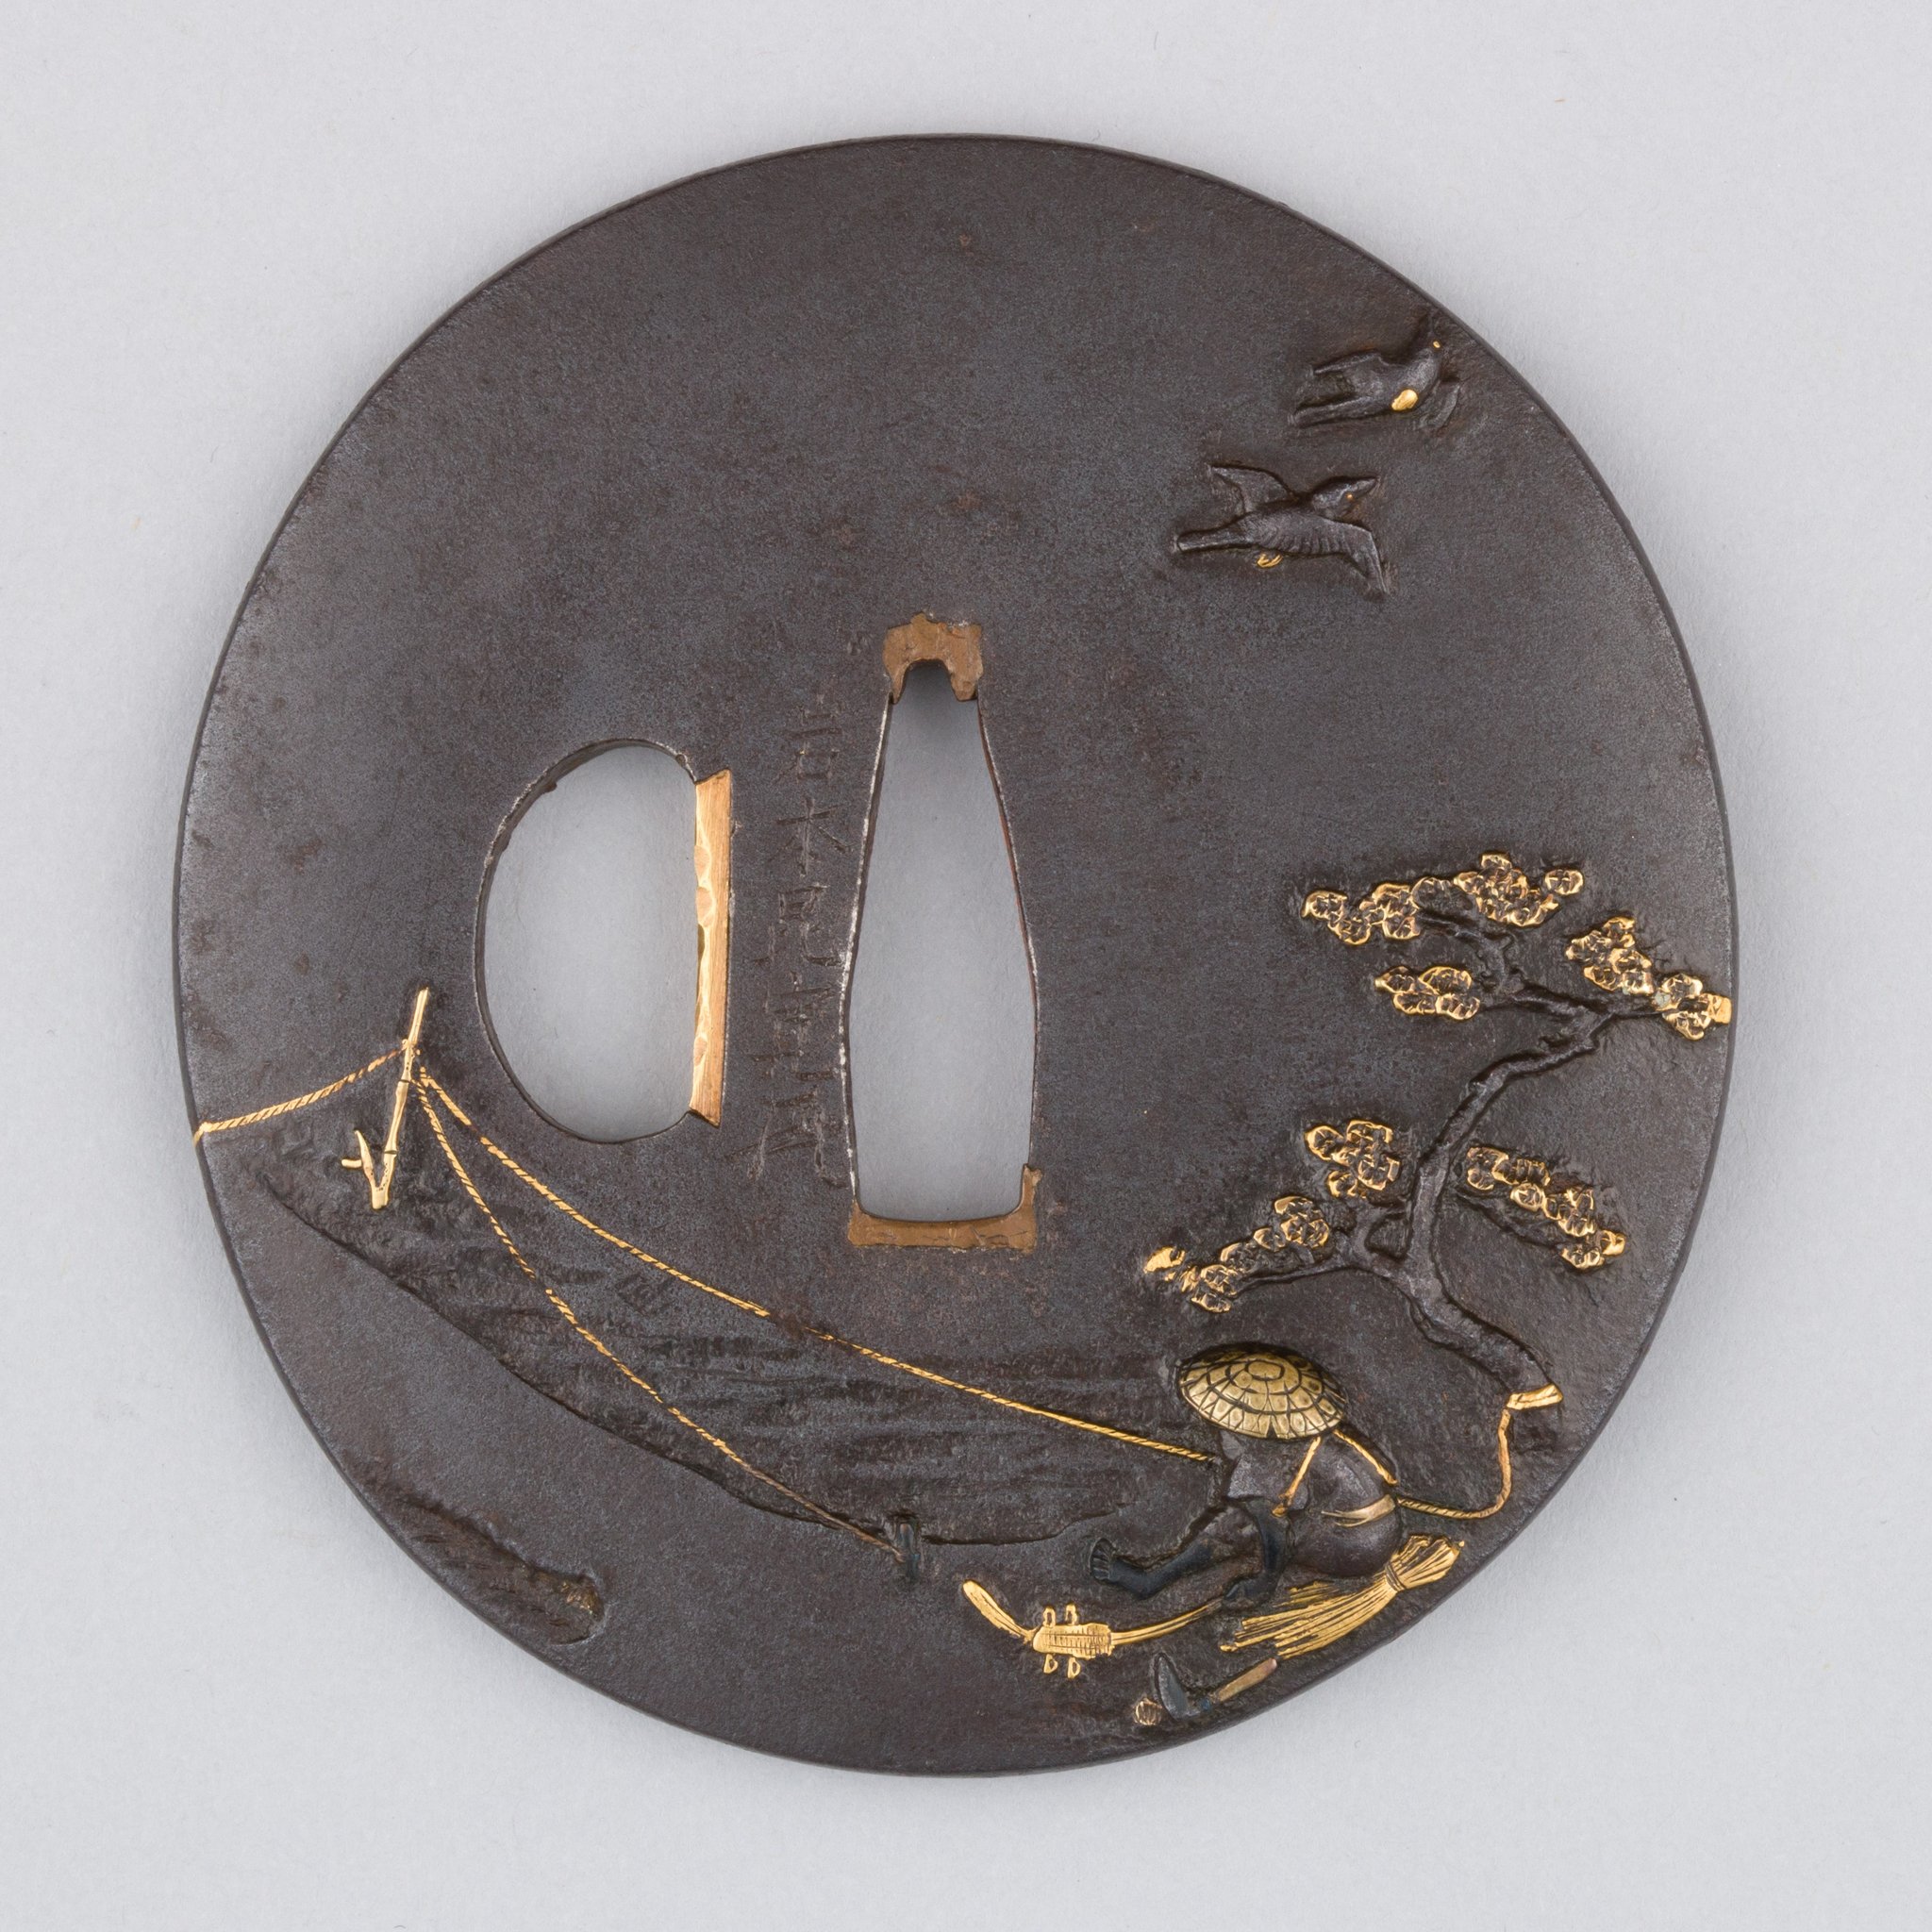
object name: sword guard tsuba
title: Sword Guard (Tsuba)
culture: japanese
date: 1800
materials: copper, gold, iron, silver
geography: japan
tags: human figures,birds